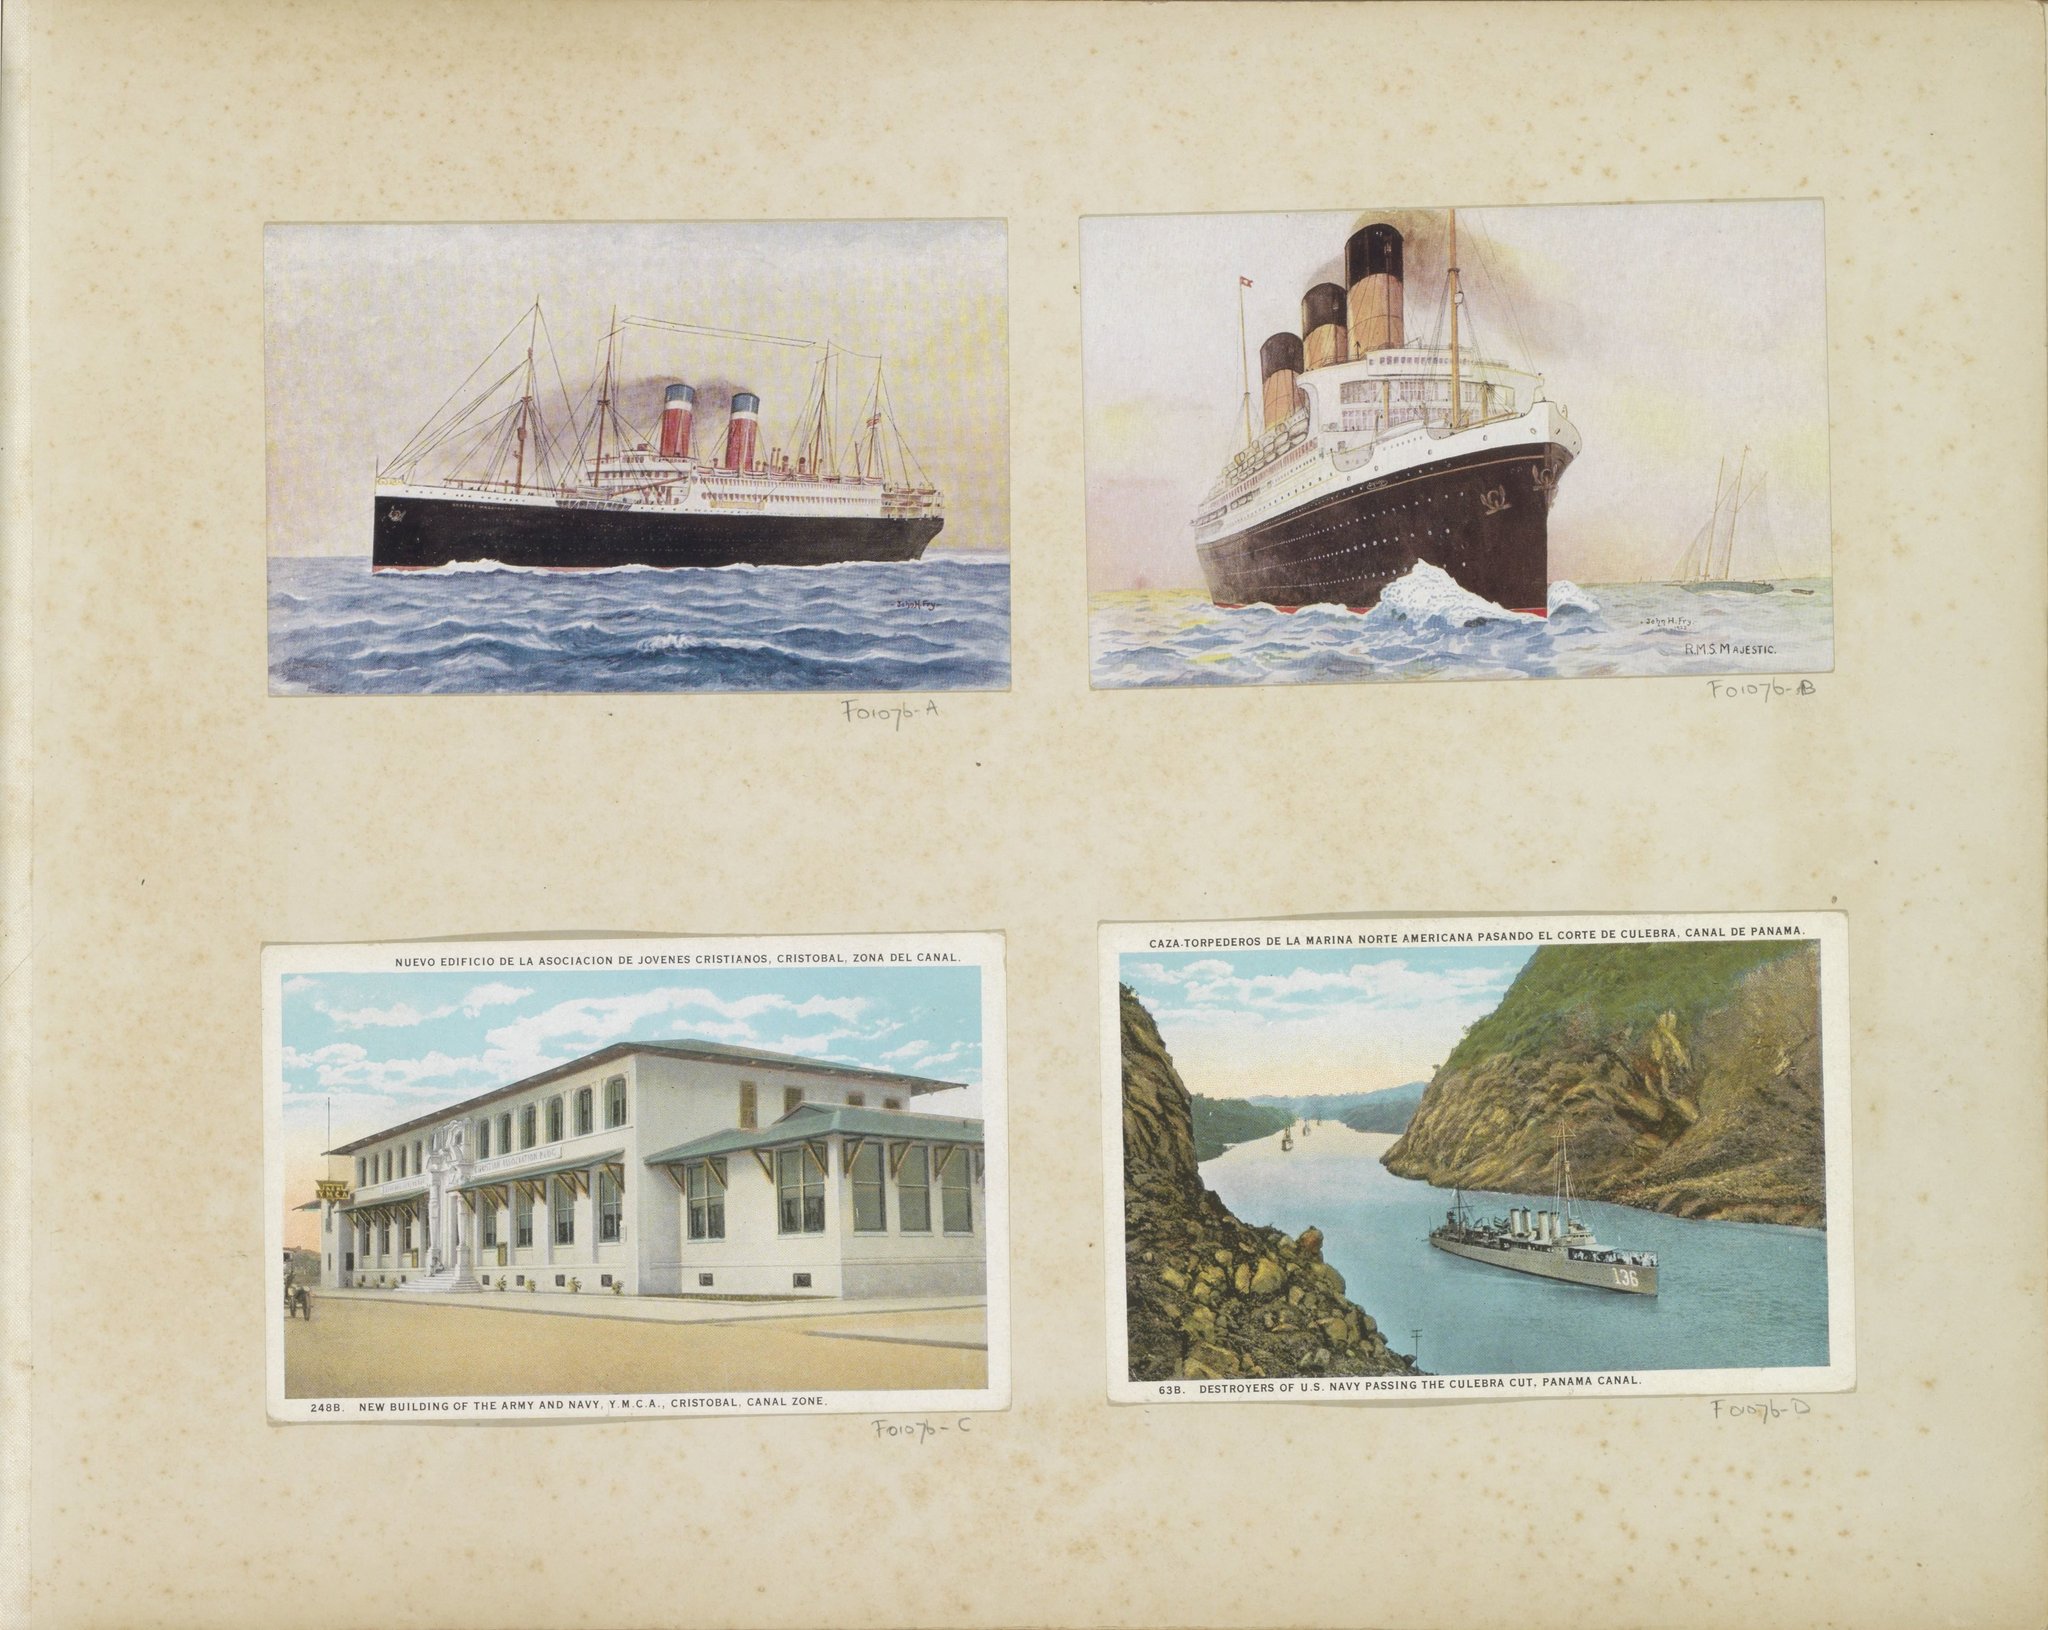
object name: ansichtkaart, prentbriefkaart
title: Fotoreproductie van (vermoedelijk) een tekening door John H. Fry van een stoomboot op zee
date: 1920-1940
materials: cardboard, paper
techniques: autotype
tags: steamship, motorship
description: Onderdeel van Album met foto's van spoorwegen in Nederlands-Indië en prentbriefkaarten.